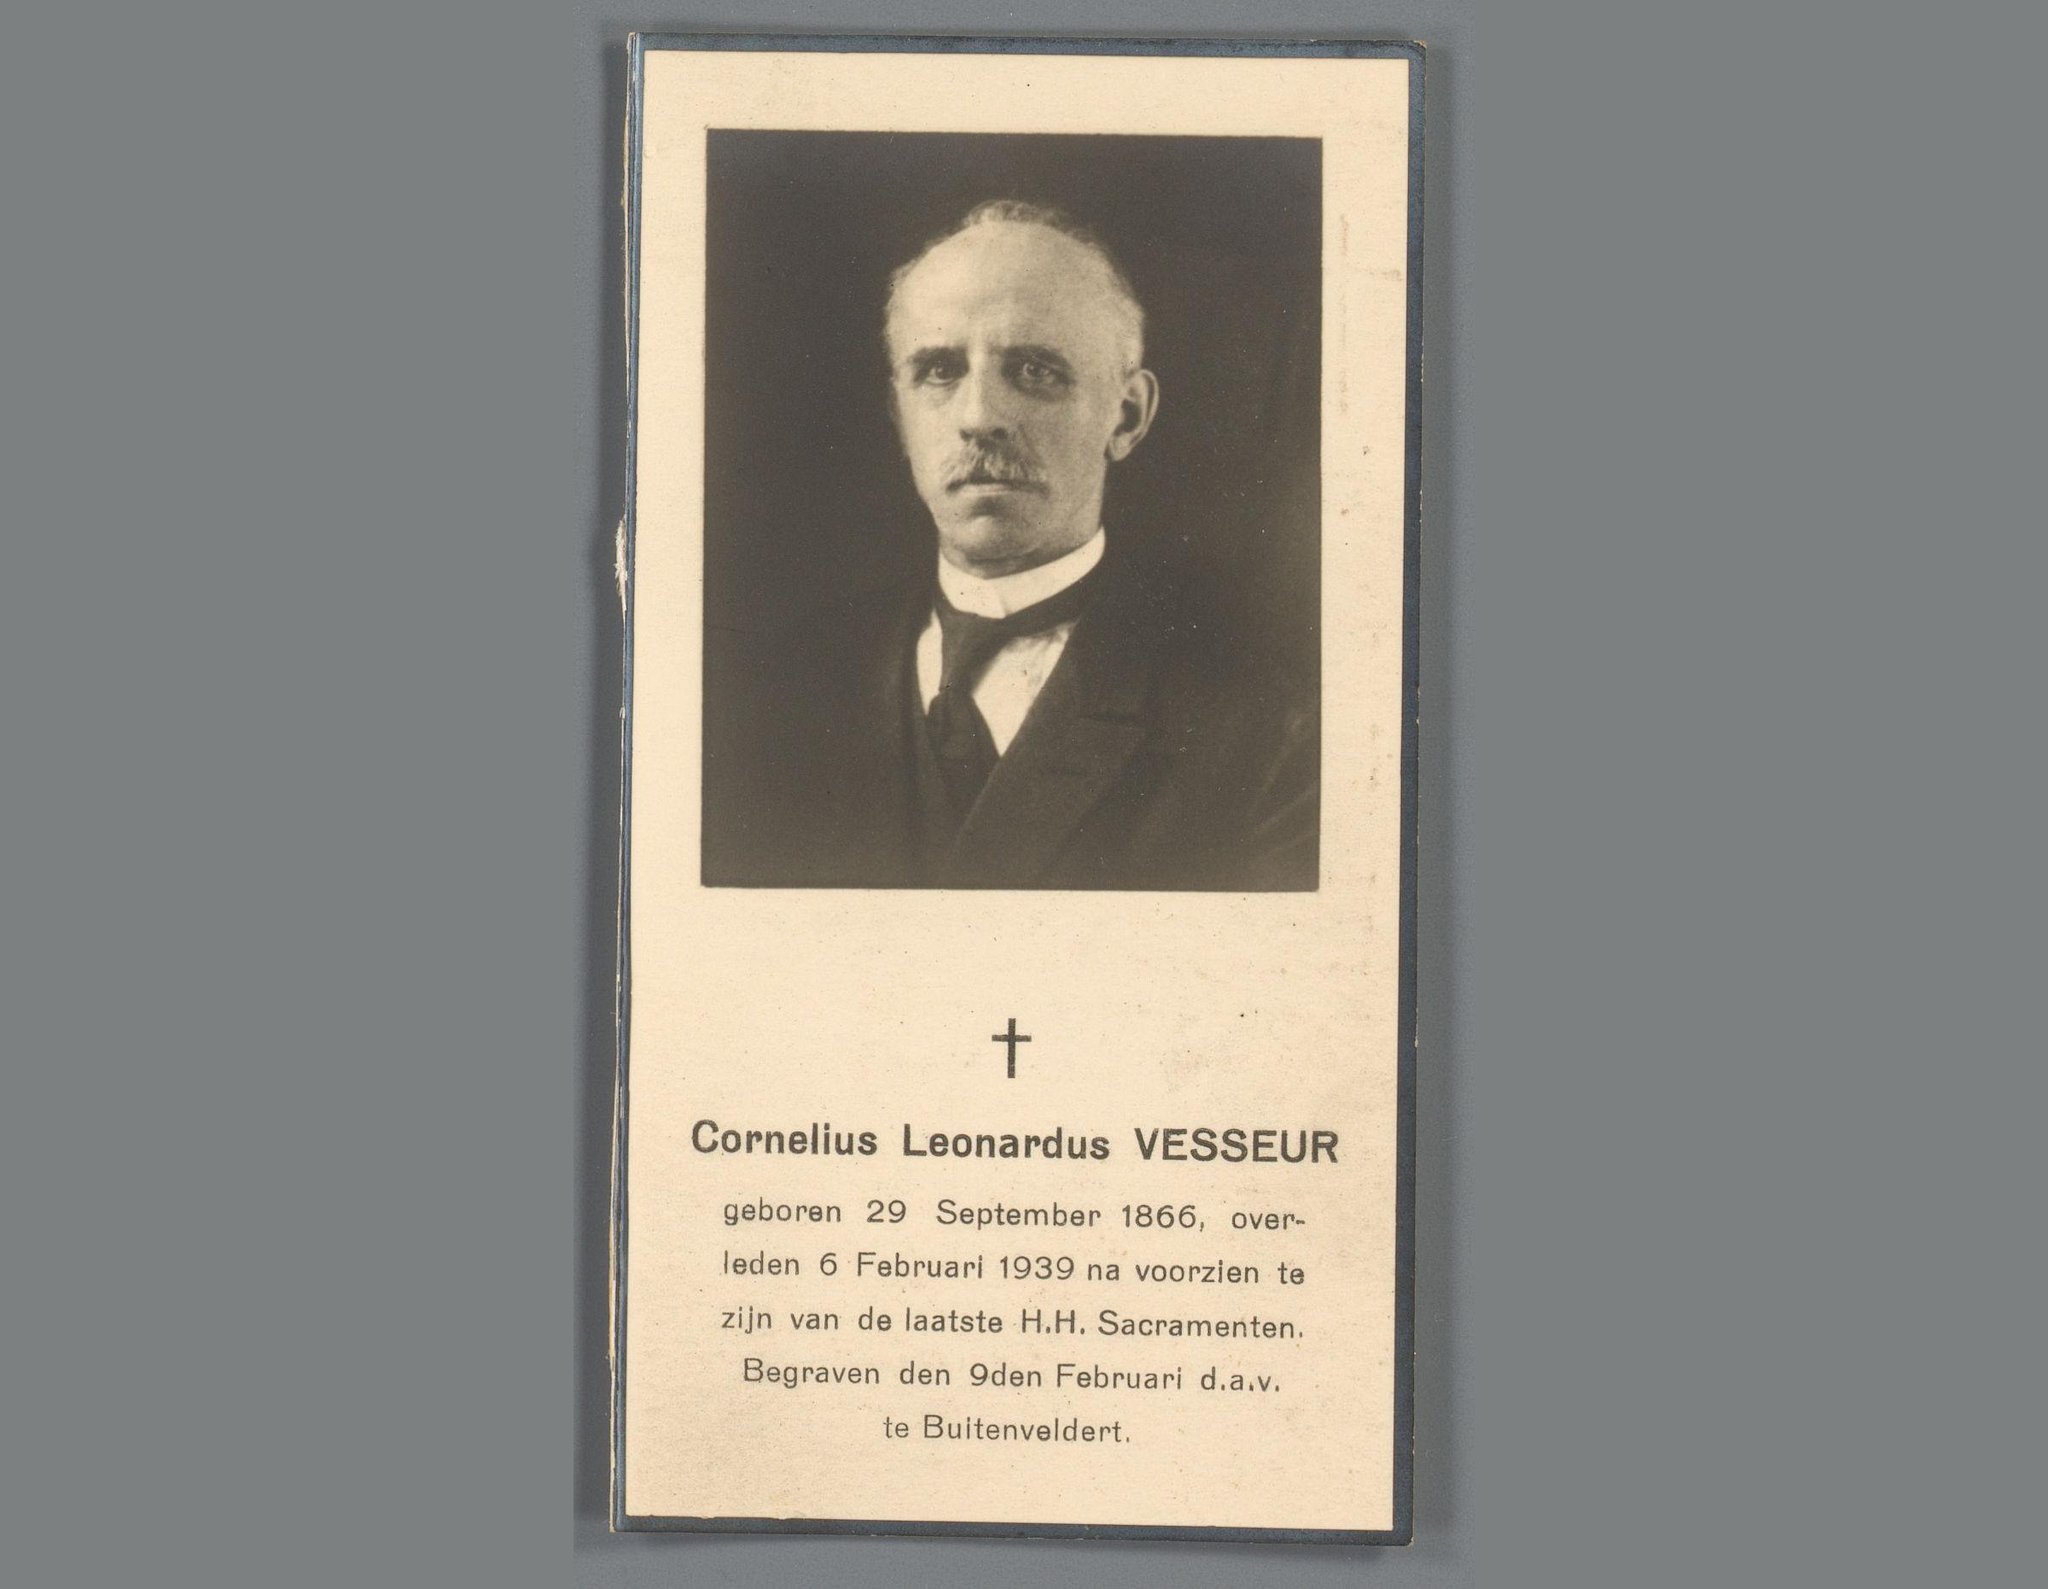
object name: prayer card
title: Portret van Cornelius Leonardus Vesseur op bidprent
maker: Anonymous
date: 1939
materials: paper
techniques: gelatin silver print, letterpress printing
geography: amsterdam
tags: historical persons, old man, amsterdam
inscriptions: inscription: ‘Cornelius Leonardus Vesseur (...) te Buitenveldert.’, inscription: ‘Gedenk in uwe gebeden de ziel van/ onze lieven vader (...) Dat hij ruste in vrede.’